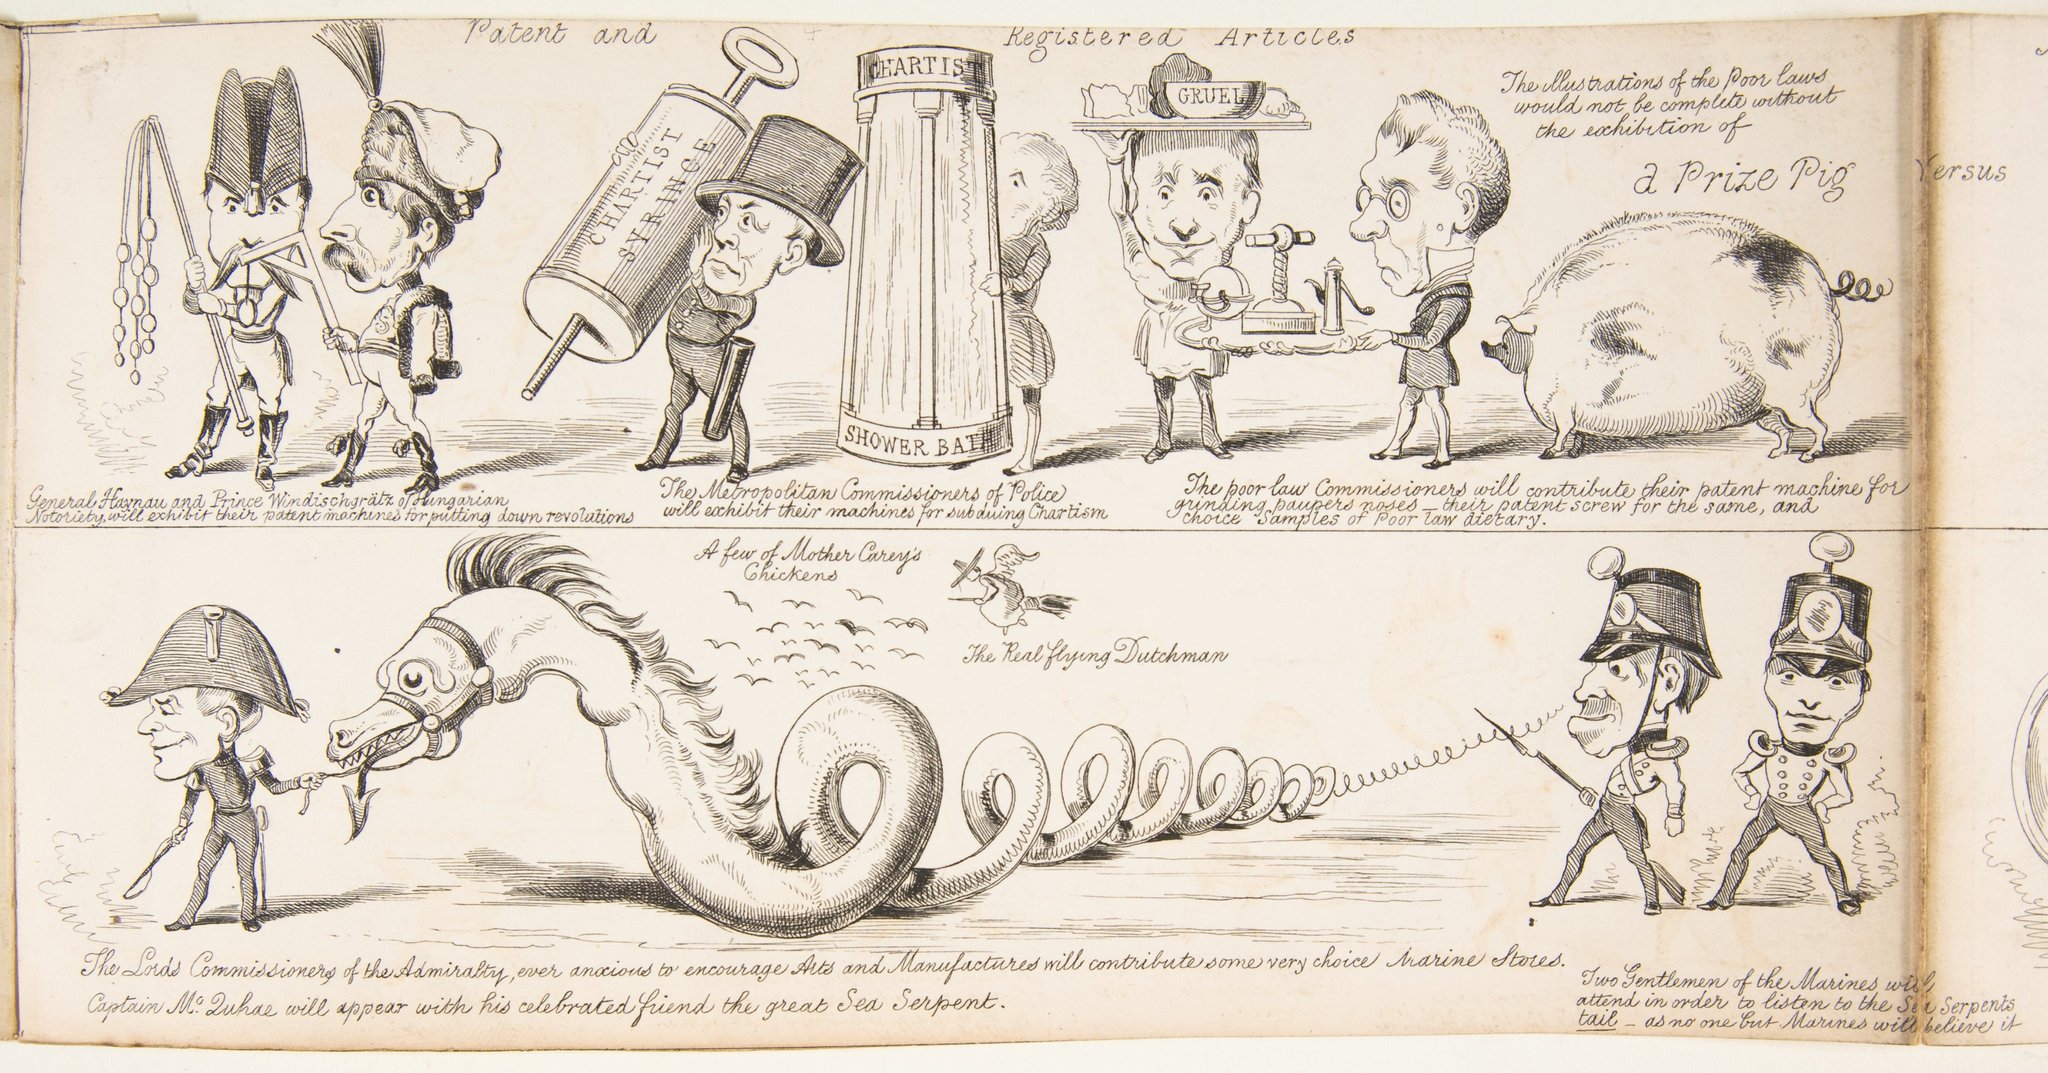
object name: print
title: The Great Exhibition "Wot is to Be", Probable Results of The Industry of All Nations in The Year '51, Showing What is to be Exhibited, Who is To Exhibit, in Short How Its All Going to Be Done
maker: george augustus sala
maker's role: author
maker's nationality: british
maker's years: 1828-1895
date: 1850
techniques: engraving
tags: men,dragons